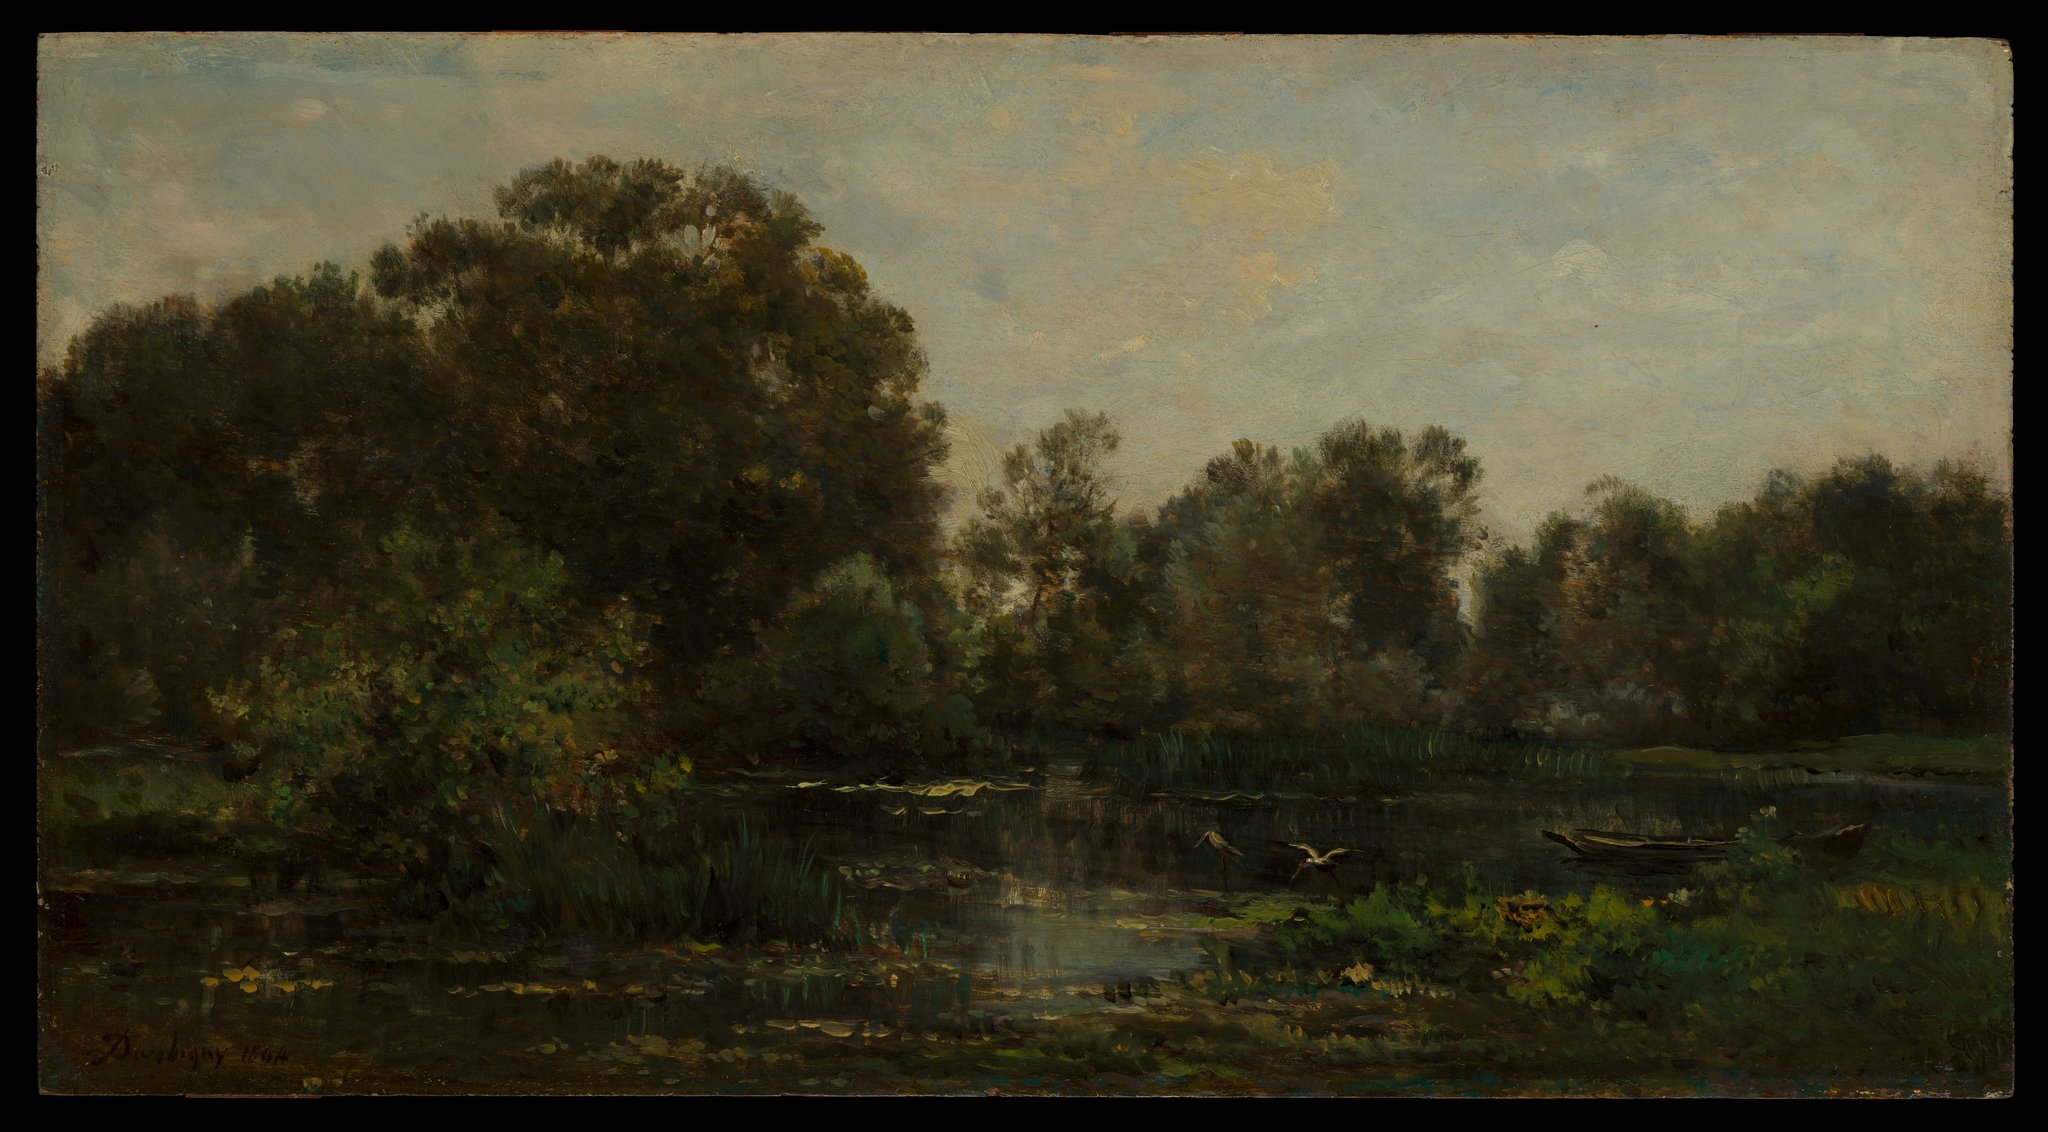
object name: painting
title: A River Landscape with Storks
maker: charles-françois daubigny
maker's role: artist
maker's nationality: french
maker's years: 1817-1878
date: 1864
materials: oil, wood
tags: birds,rivers,landscapes